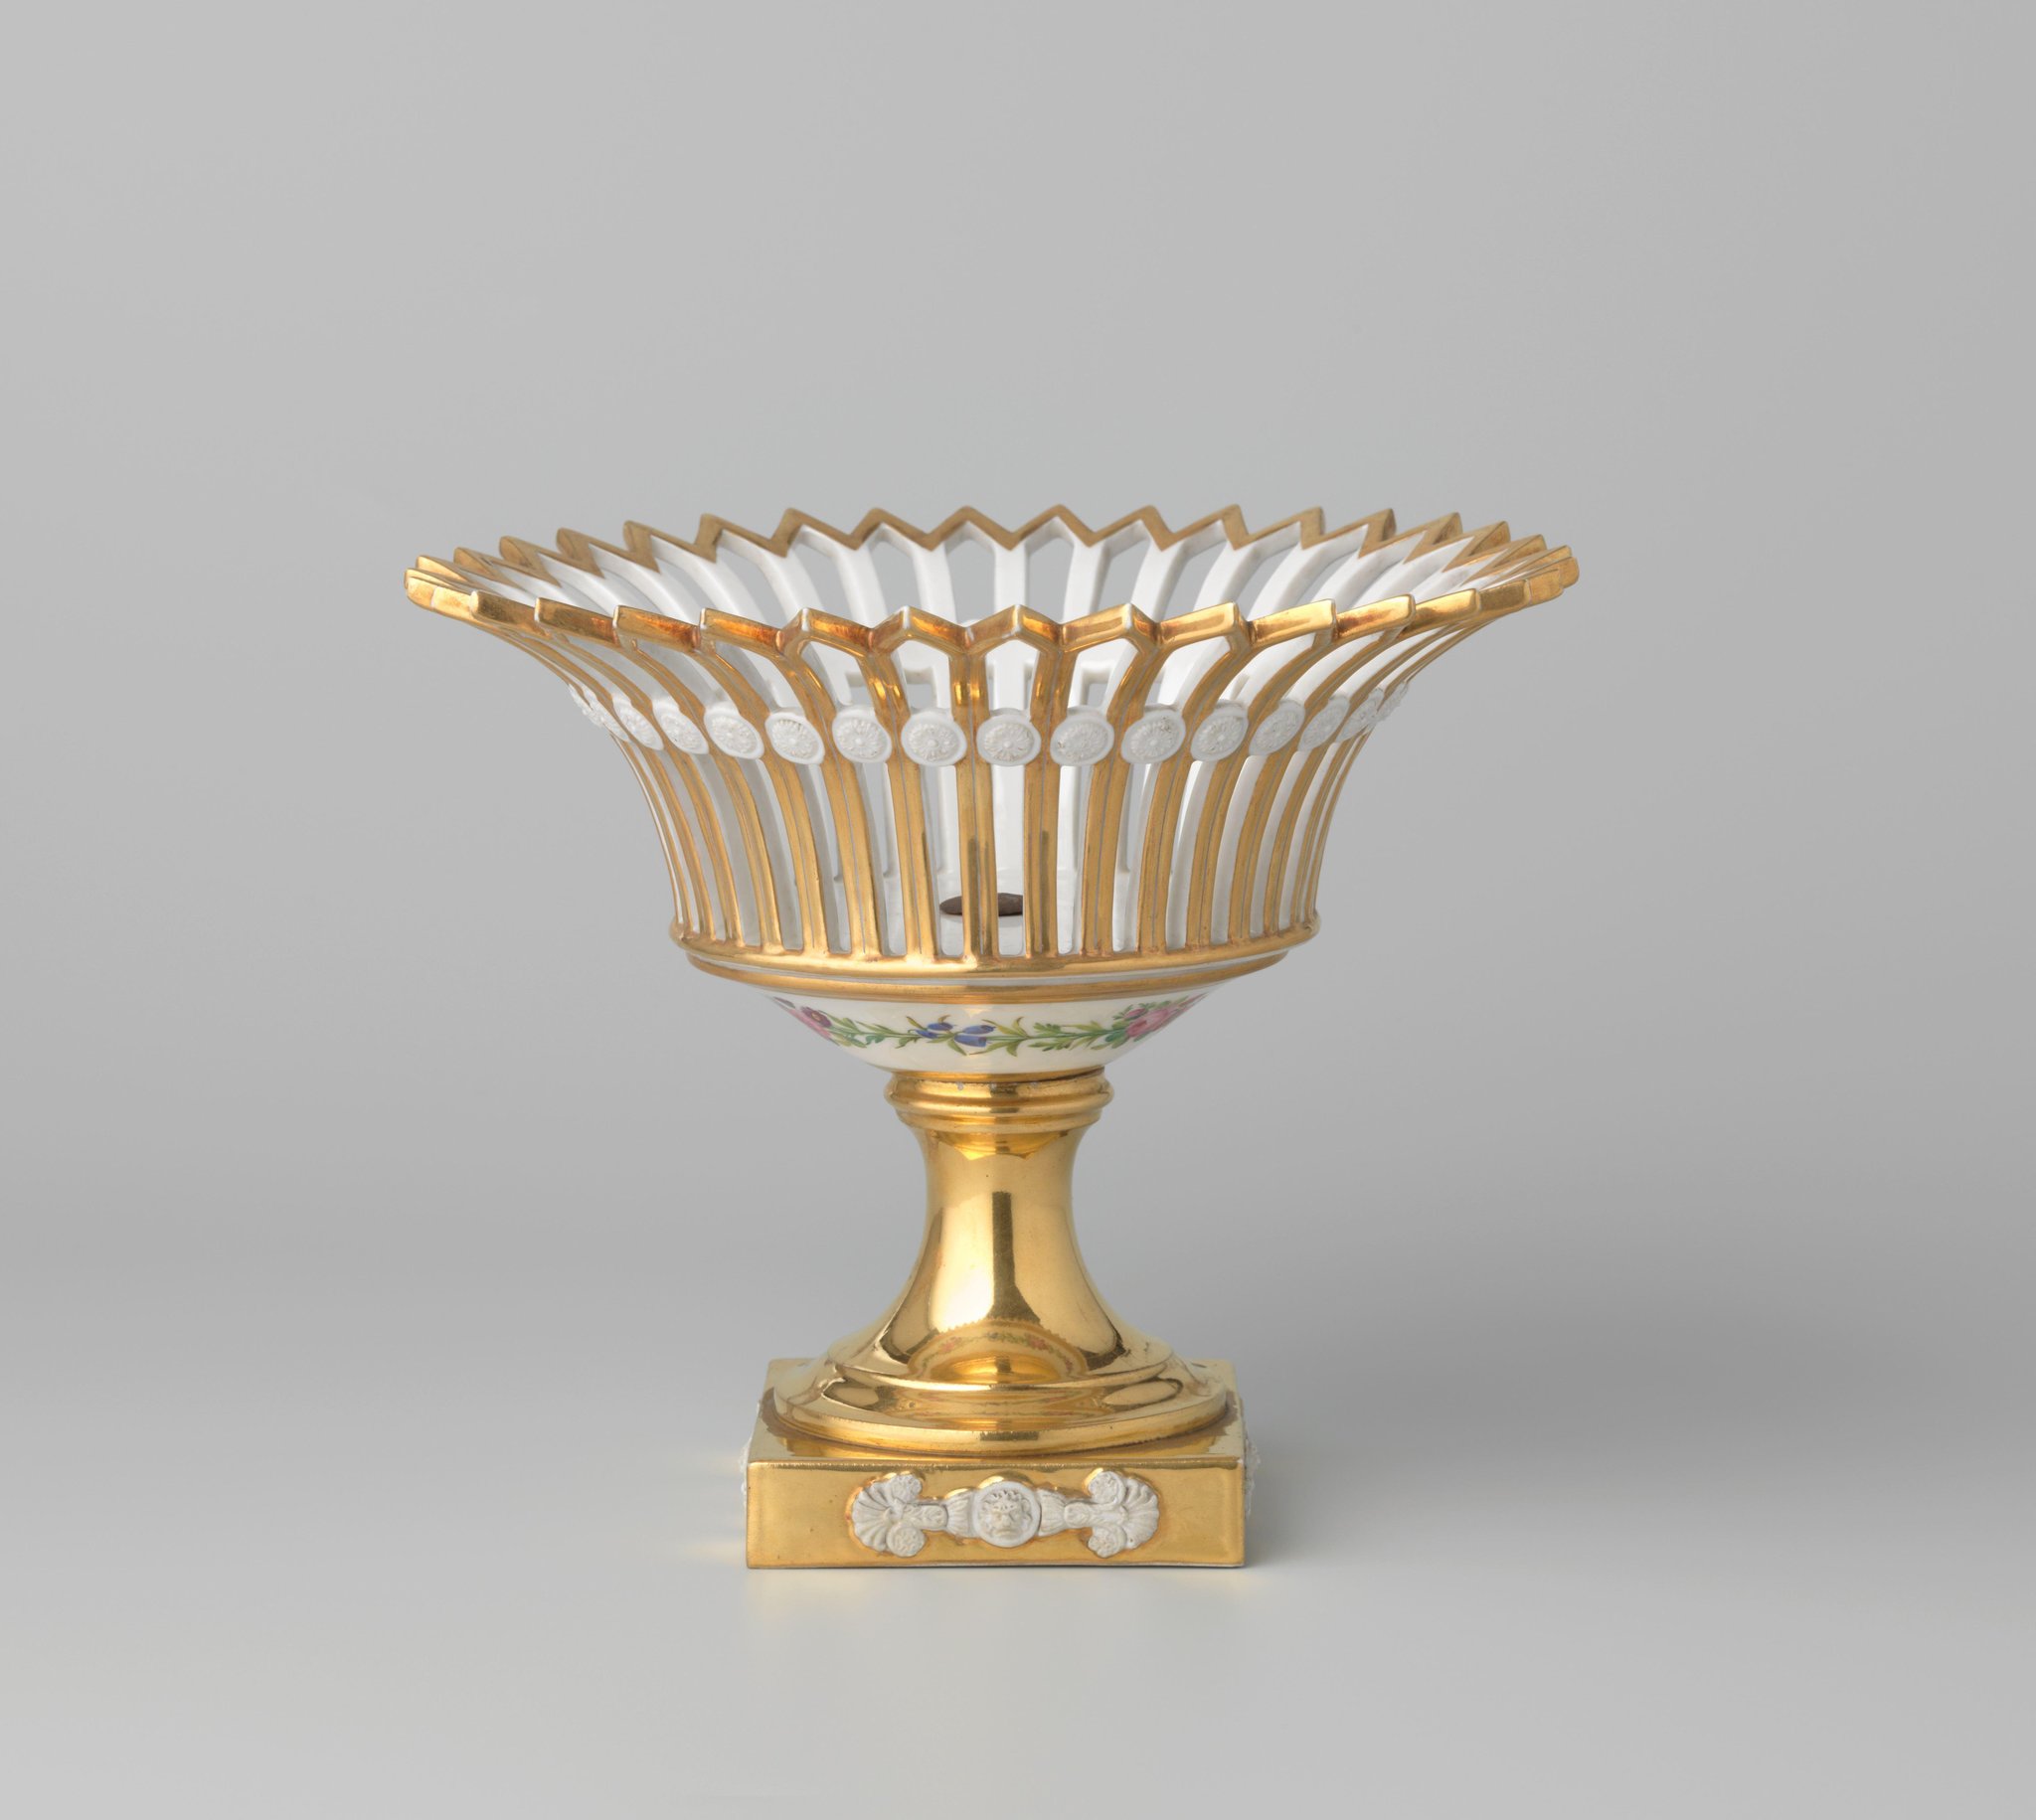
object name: fruit bowl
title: Dish on high foot with pierced sides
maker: Anonymous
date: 1800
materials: glaze, gold, paint, porcelain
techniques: firing, forming, gilding, turning, vitrification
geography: france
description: Schaal van porselein op een hoge, spreidende voet eindigend in een vierkant voetstuk en met een opengewerkte wand met gekartelde rand. Beschilderd op het glazuur in blauw, rood, roze, groen, geel, paars en goud. Halverwege de opengewerkte wand een dichte band met bloemen. De onderzijde van de schaal met bloemtakken. Op elke zijde van het voetstuk een gemodelleerde bloemrank in biscuit. De schaal en de voet zijn verbonden door middel van een ijzeren pin.